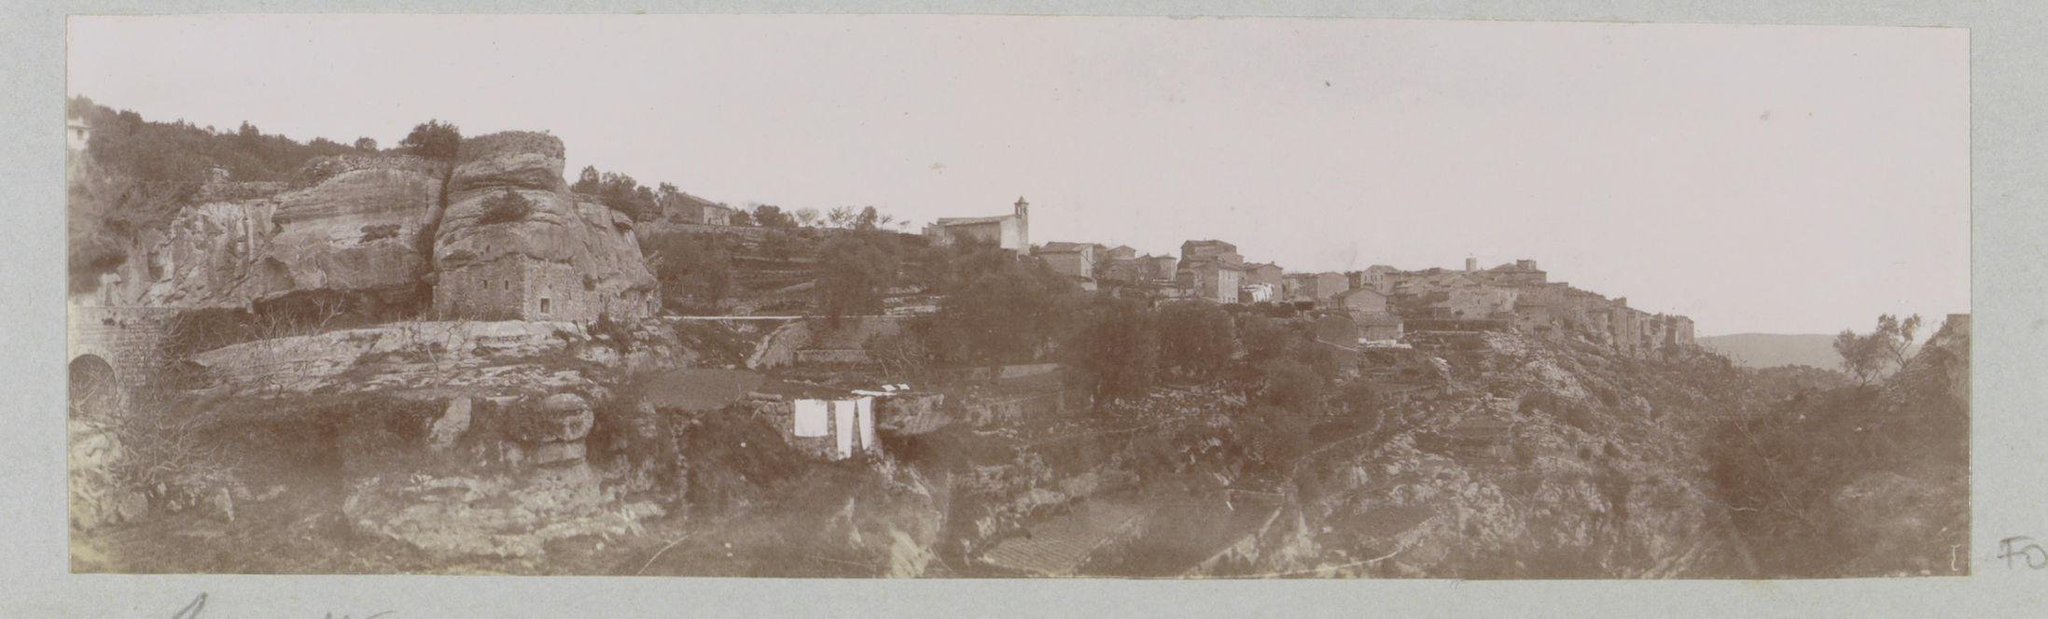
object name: photograph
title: Gezicht op Tourrettes-lès-Vence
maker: delizy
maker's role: manufacturer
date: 1903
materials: paper, photographic support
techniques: gelatin silver print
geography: tourrettes-lès-vence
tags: prospect of village, silhouette of village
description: Onderdeel van Fotoalbum van een Franse amateurfotograaf met opnames van uitstapjes in Frankrijk, Spanje, België, Luxemburg en Nederland, de eerste automobielen en autoraces.